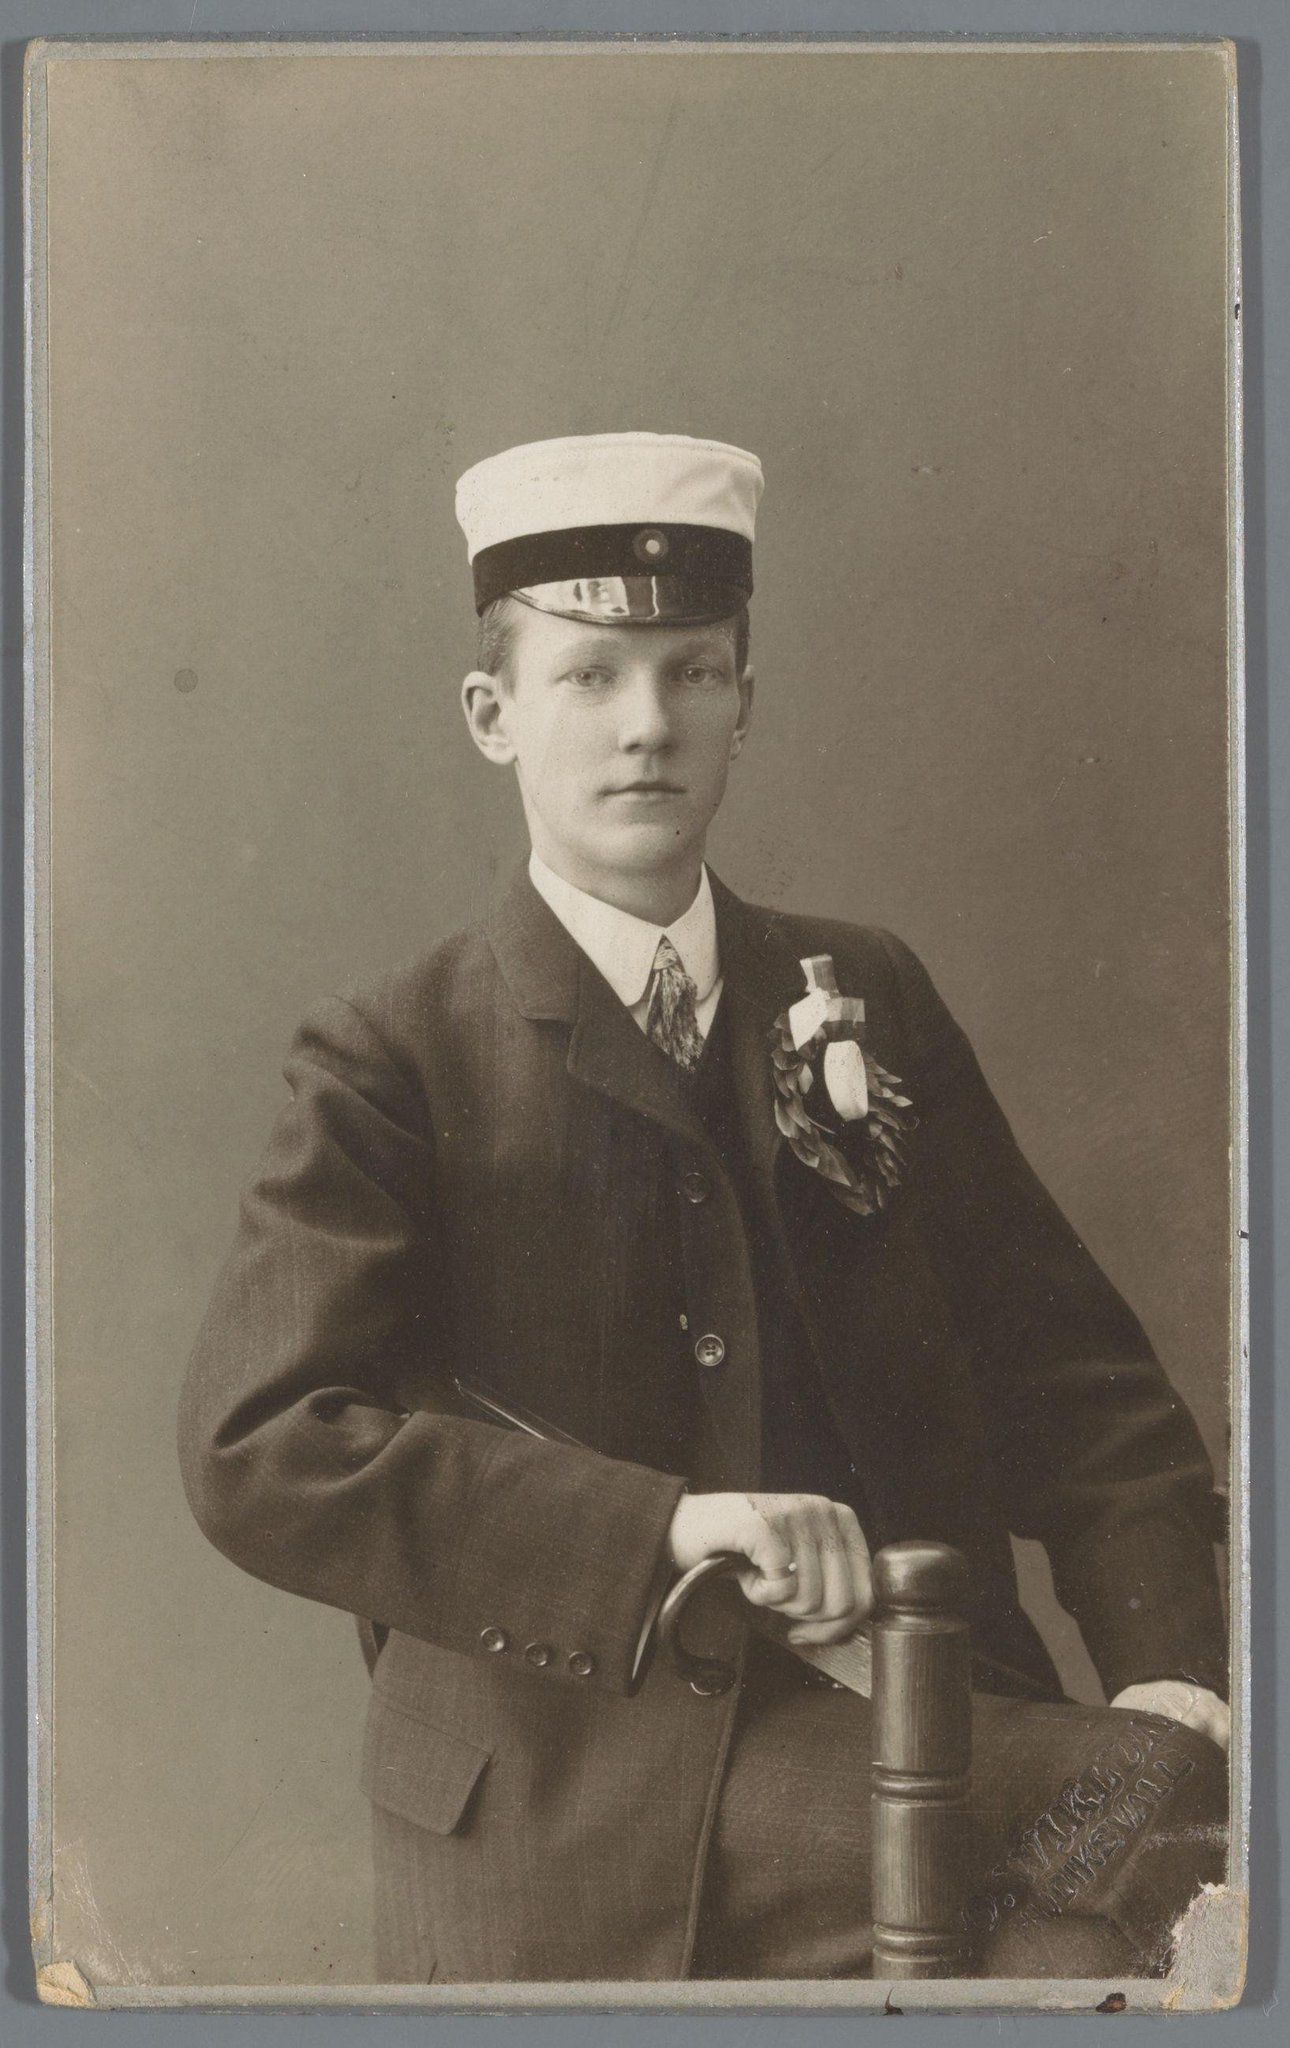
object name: carte de visite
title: Portret van een onbekende student met wandelstok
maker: johan olaf wiklund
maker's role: fotograaf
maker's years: -1920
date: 1889-1911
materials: paper, cardboard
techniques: gelatin silver print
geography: hudiksvall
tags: youth, adolescent, anonymous historical person portrayed, student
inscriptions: inscription: ‘Plåten förvaras för/ efterbeställning’